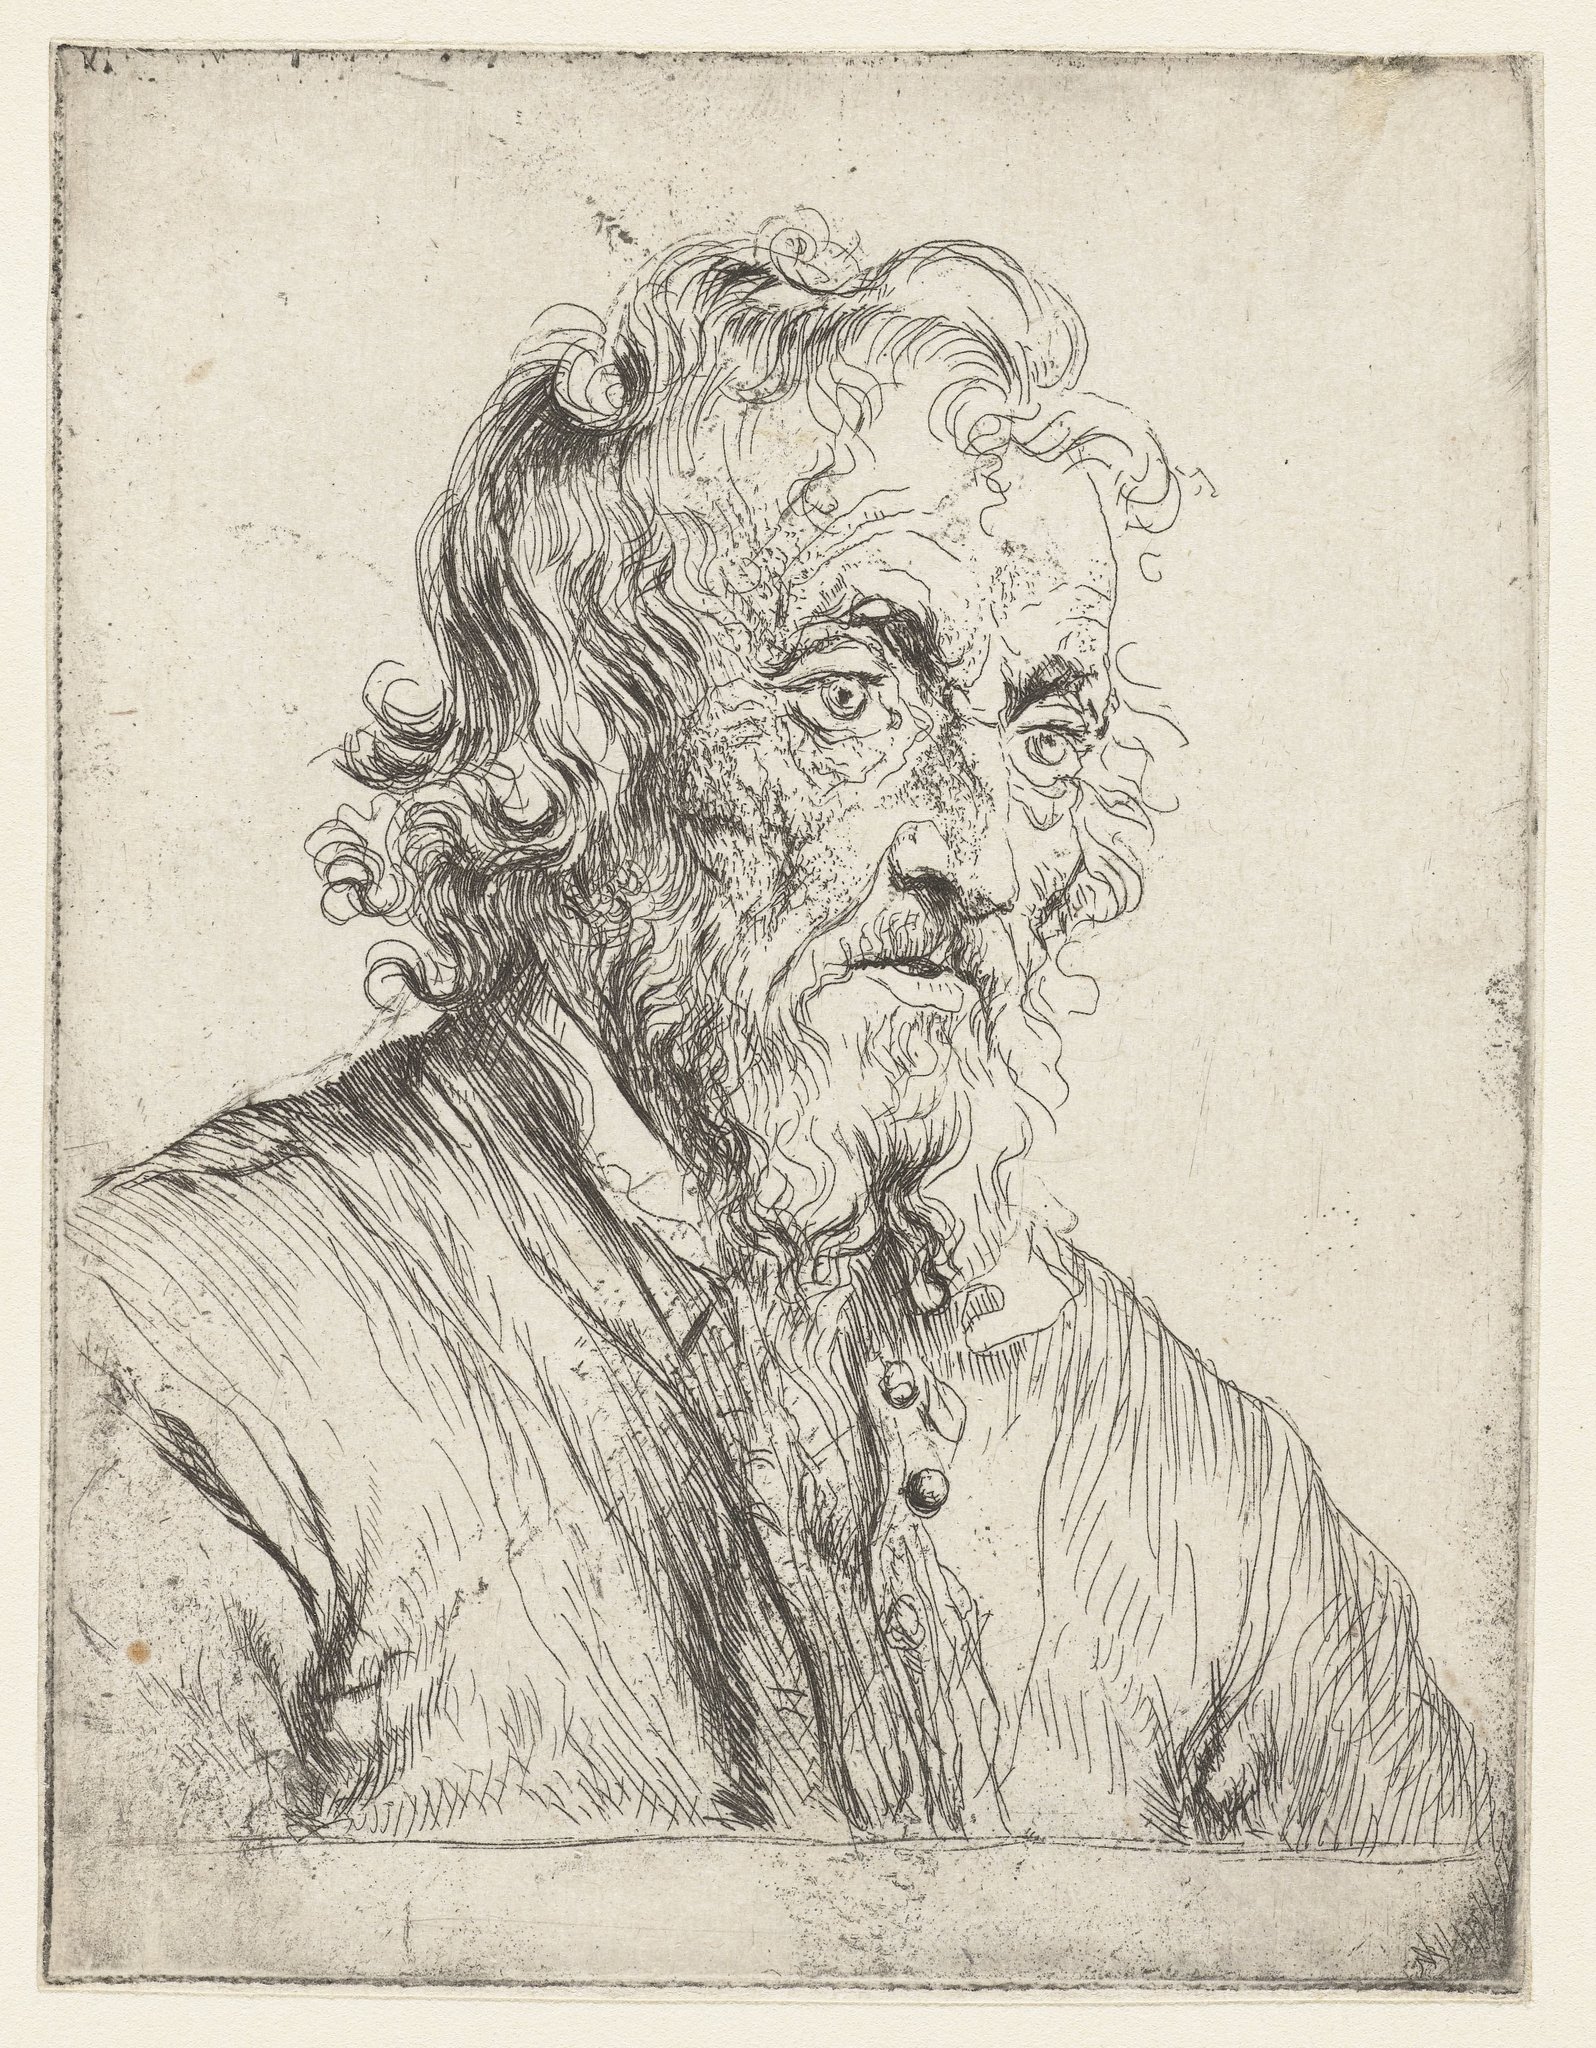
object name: print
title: Buste van een oude man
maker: salomon koninck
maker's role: draughtsman, painter, print maker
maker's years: 1609-1656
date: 1619-1656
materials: paper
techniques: etching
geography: netherlands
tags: old man (+ three-quarter view)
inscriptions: collector's mark: Lugt 240